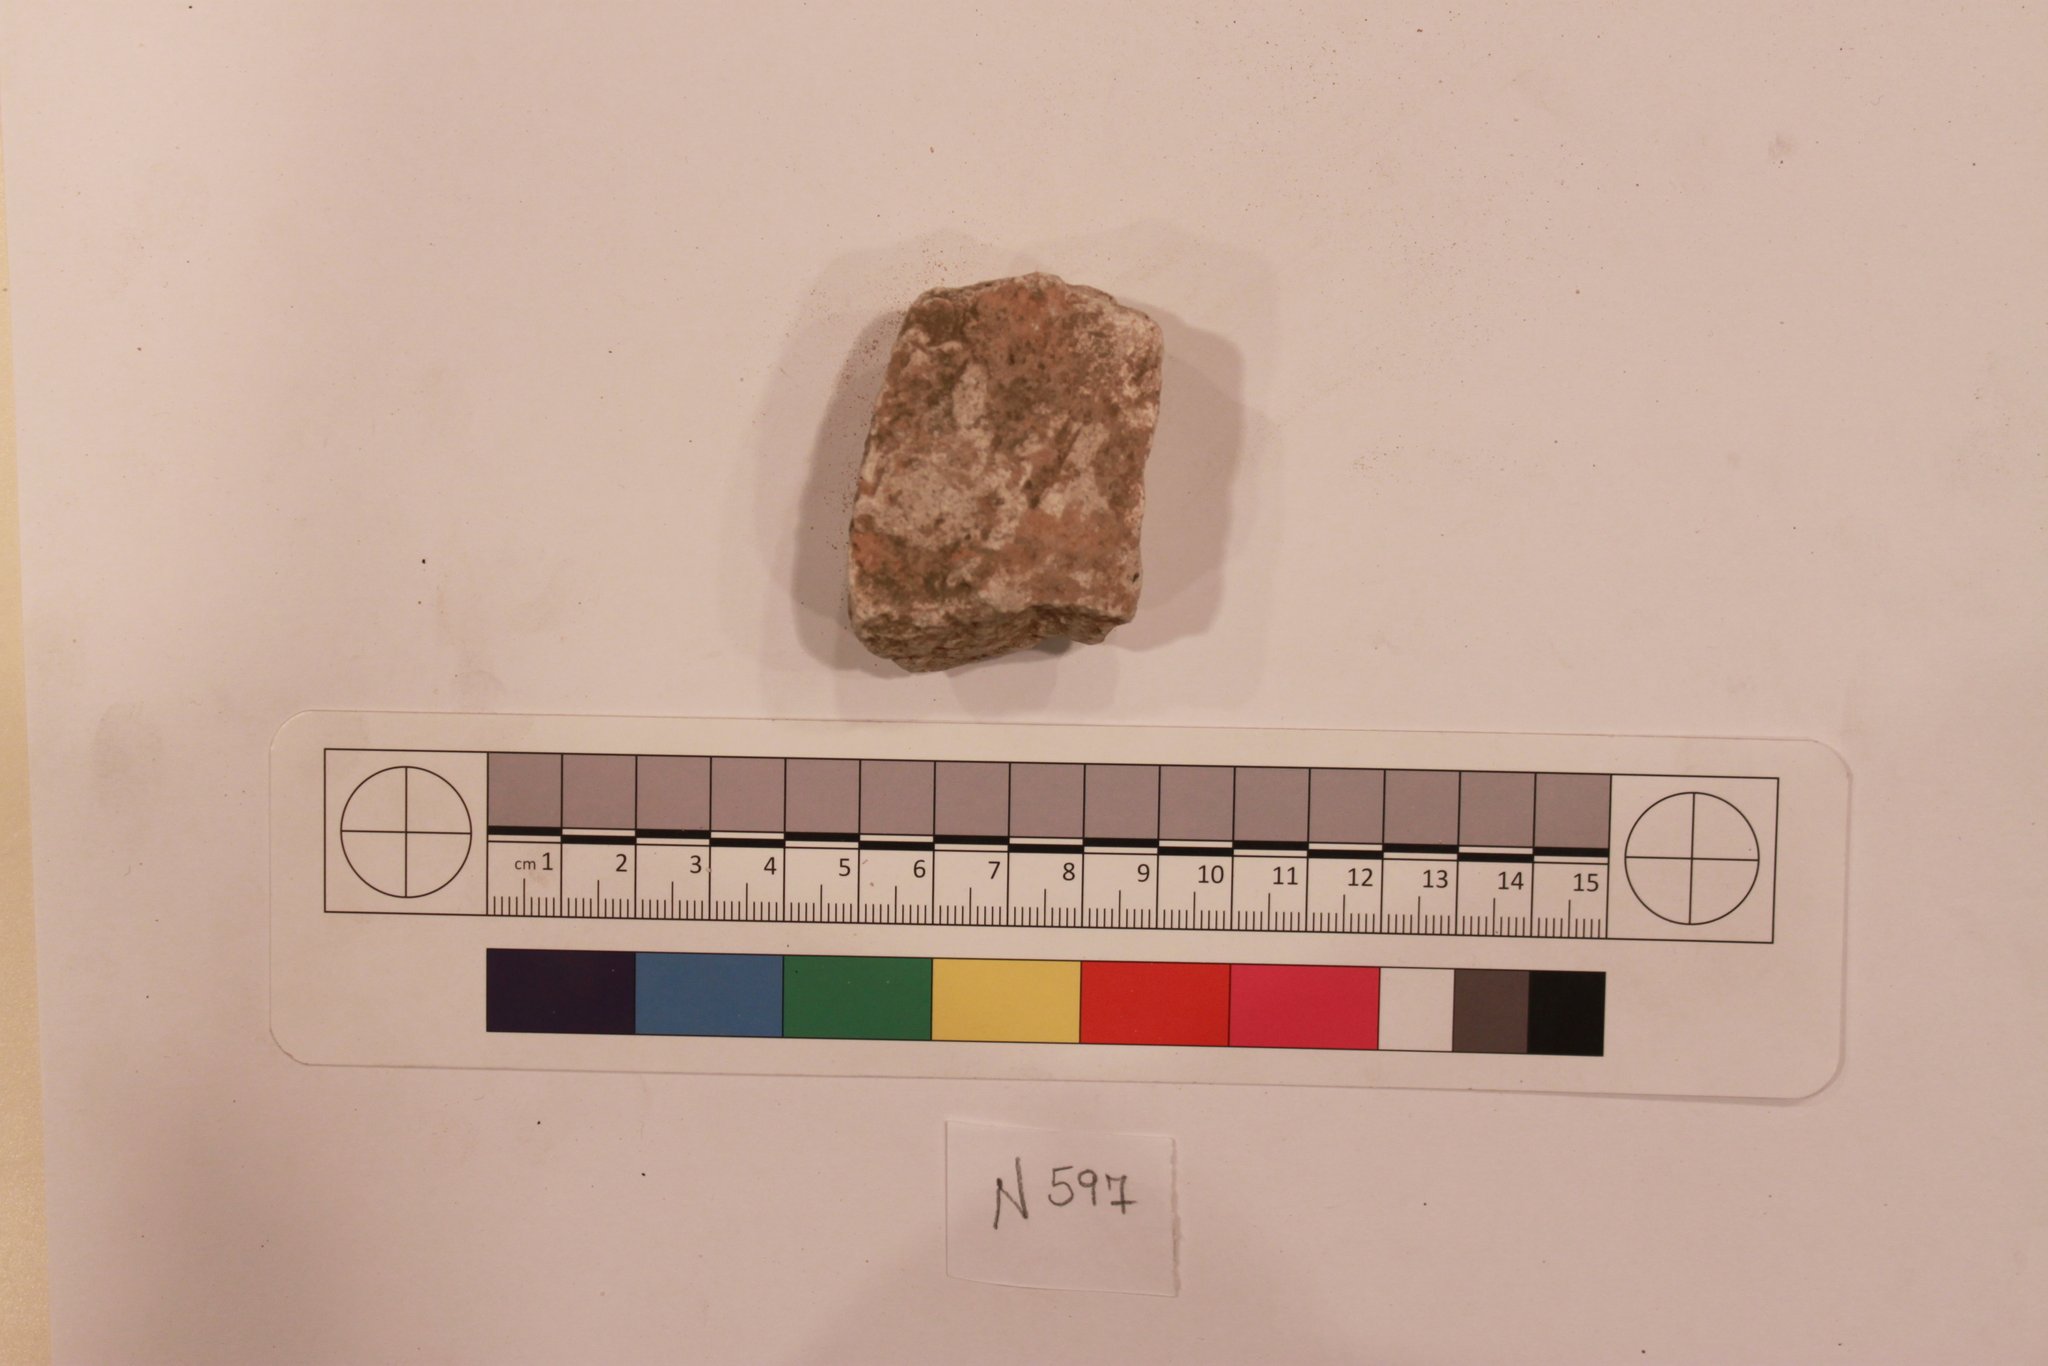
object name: fragment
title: Stucco Fragment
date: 701-1200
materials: plaster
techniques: carving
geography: iran